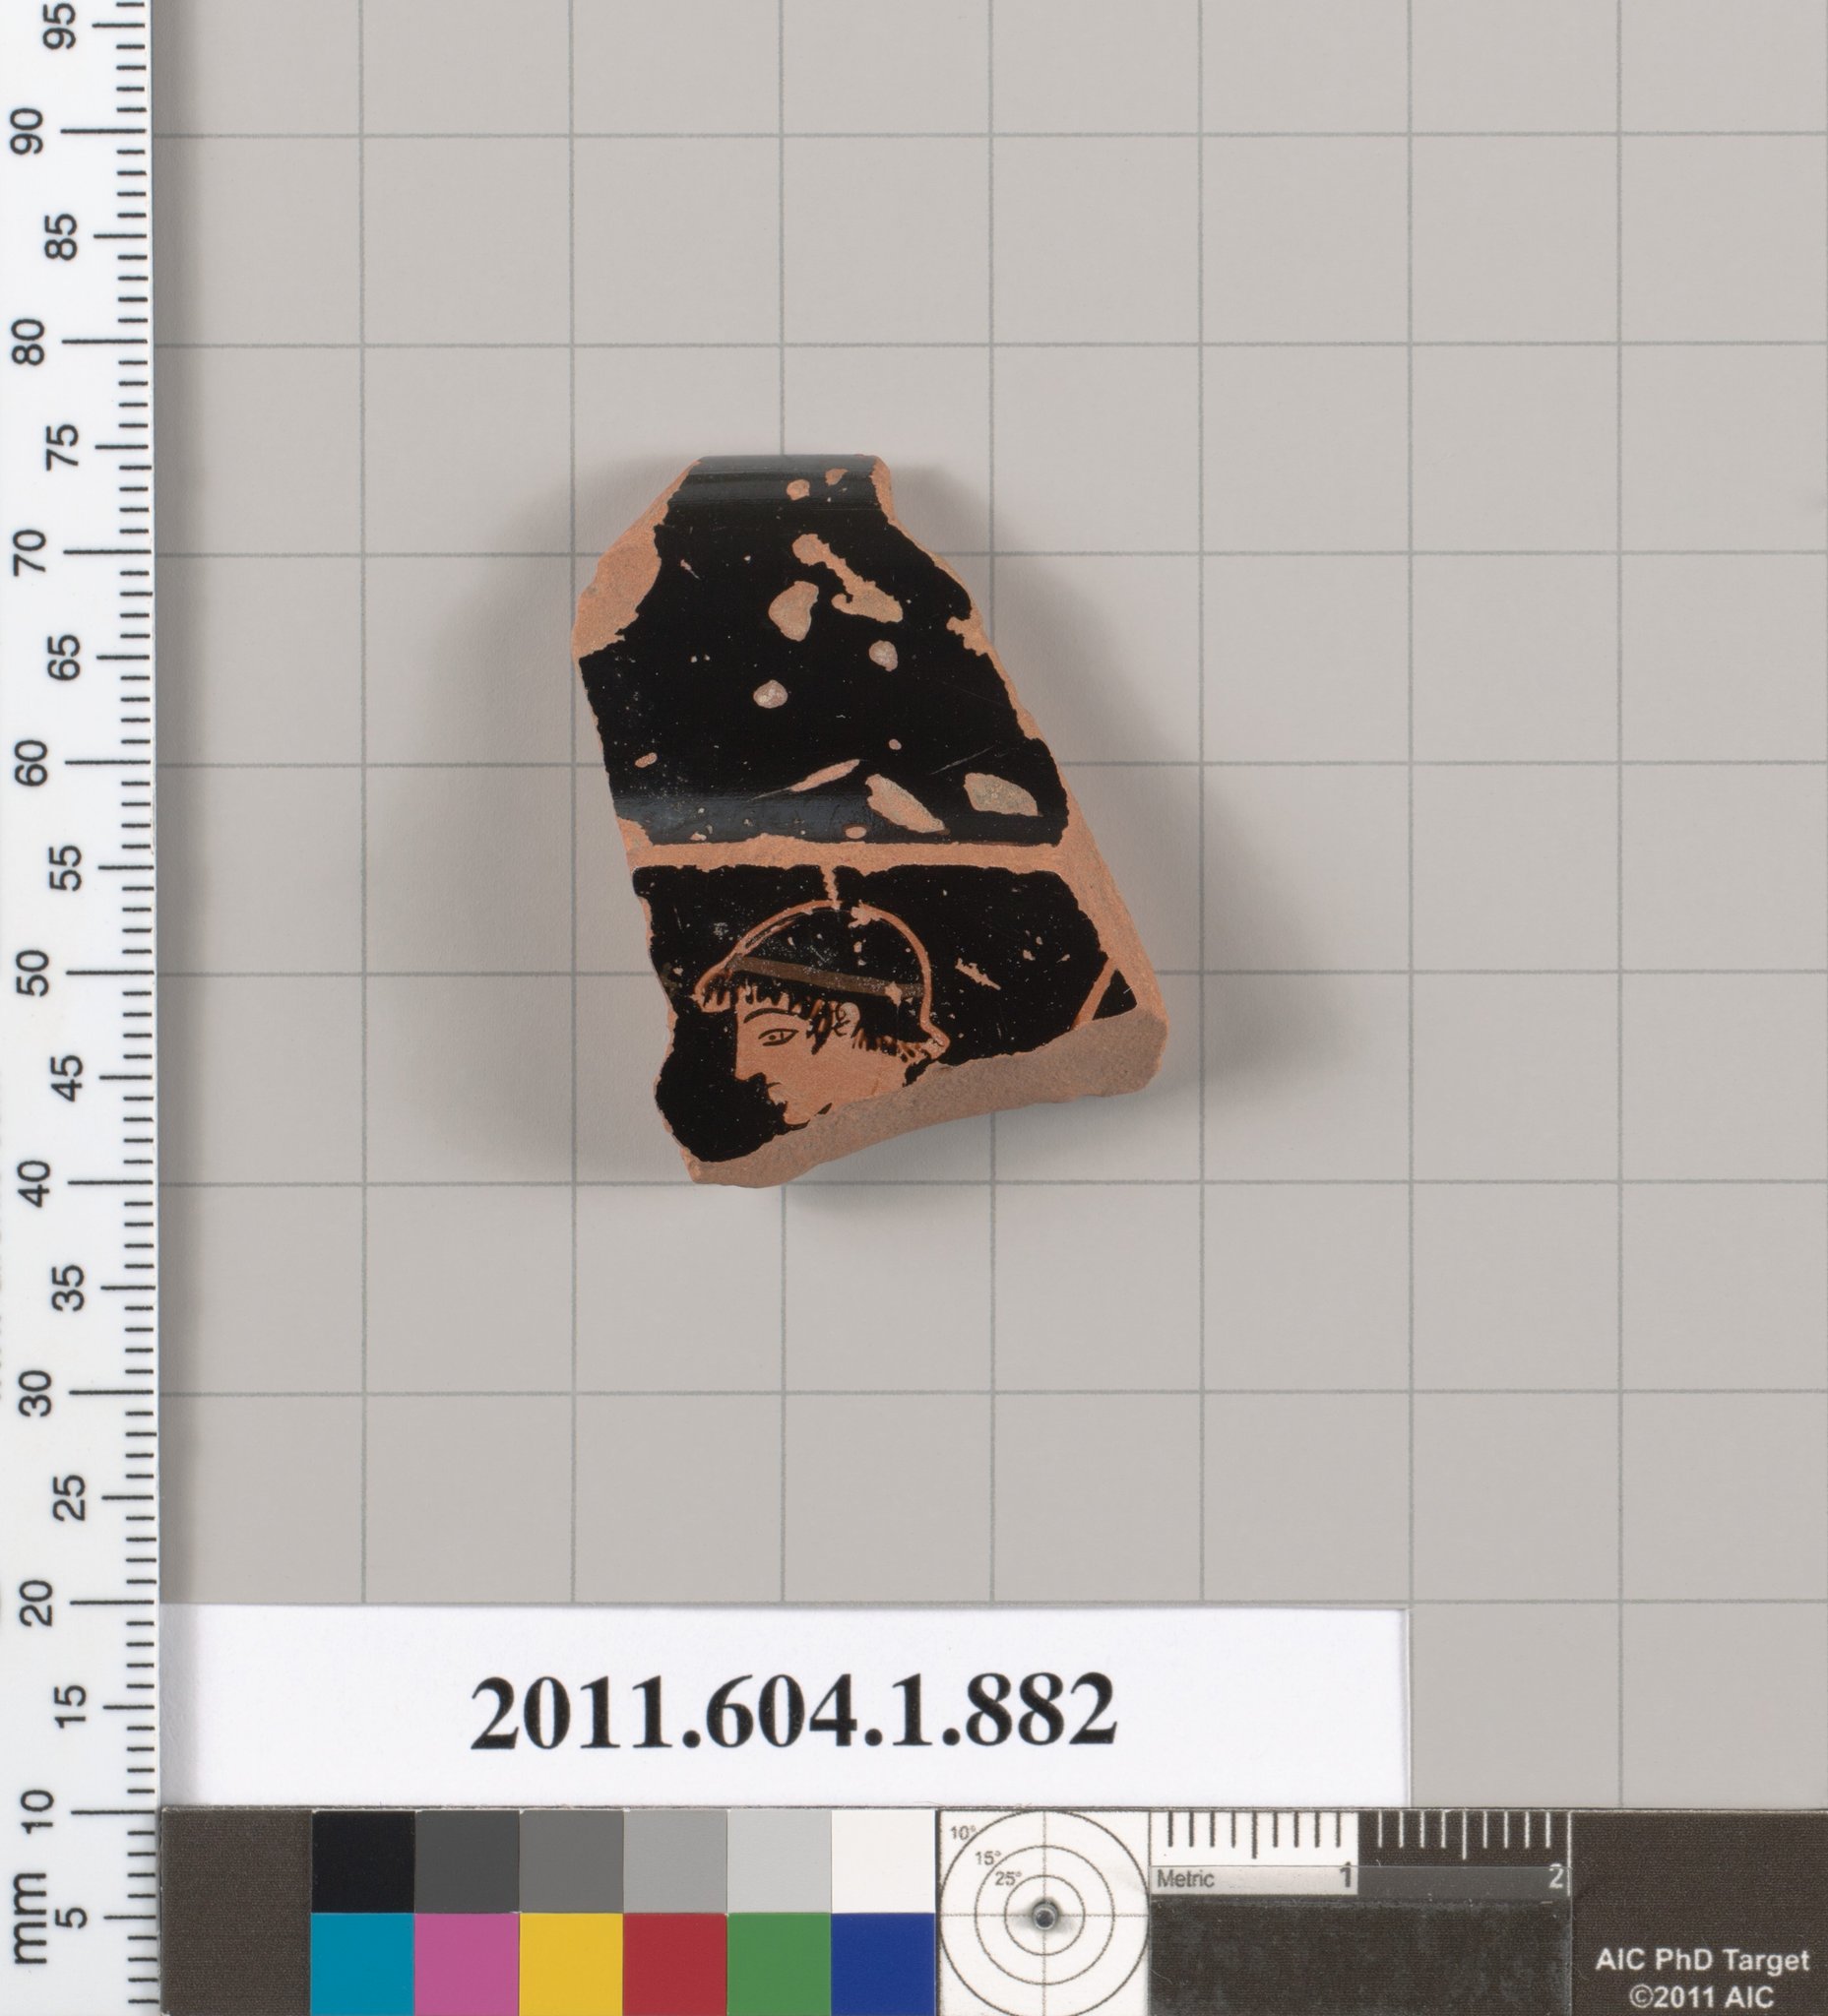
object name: kylix fragment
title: Terracotta rim fragment of a kylix (drinking cup)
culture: greek, attic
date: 475-451 BCE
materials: terracotta